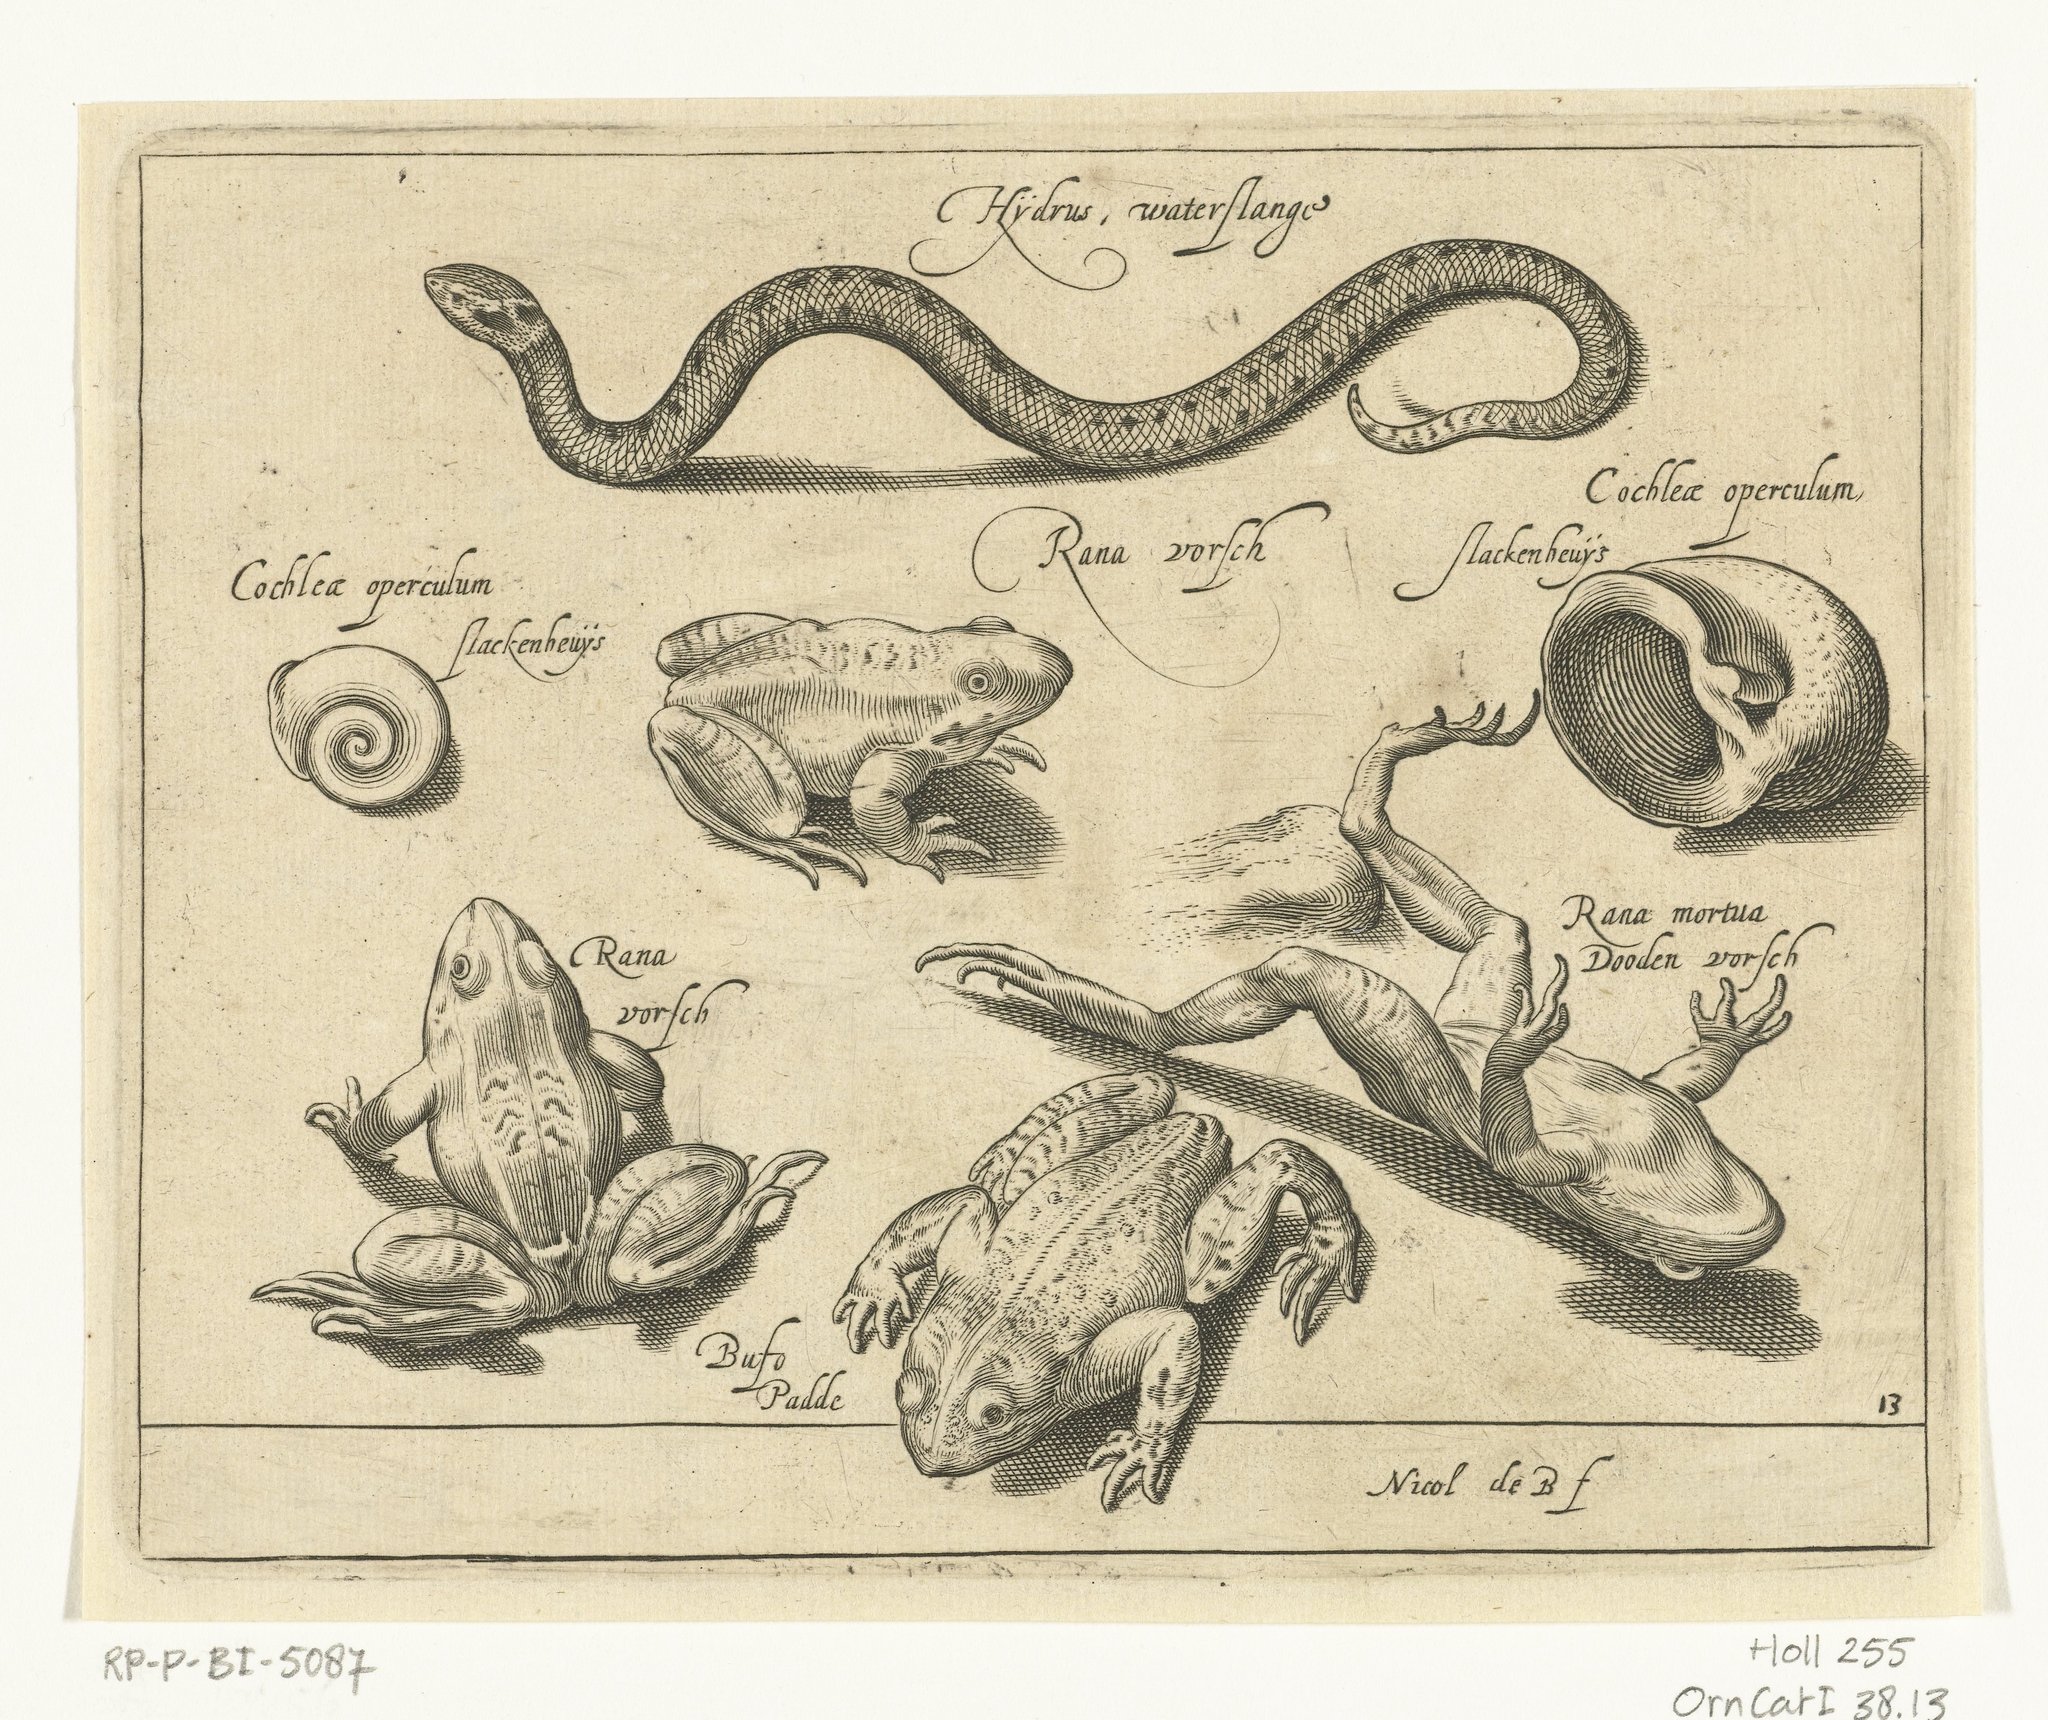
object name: print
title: Libelivs varia Genera piscium complectens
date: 1581-1656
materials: paper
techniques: engraving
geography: netherlands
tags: tailless amphibians: frog, snakes, tailless amphibians: toad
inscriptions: collector's mark: Lugt 2228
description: Prent uit serie Libelivs varia Genera piscium complectens van dertien prenten met zoetwatervissen, zeevissen, kikkers, schaaldieren en zeewezens (inclusief titelprent). Vermoedelijk ging een uitgave van Assuerus van Londerseel vooraf aan deze editie van Francoys van Beusekom, zie De Groot 1988, p. 38.